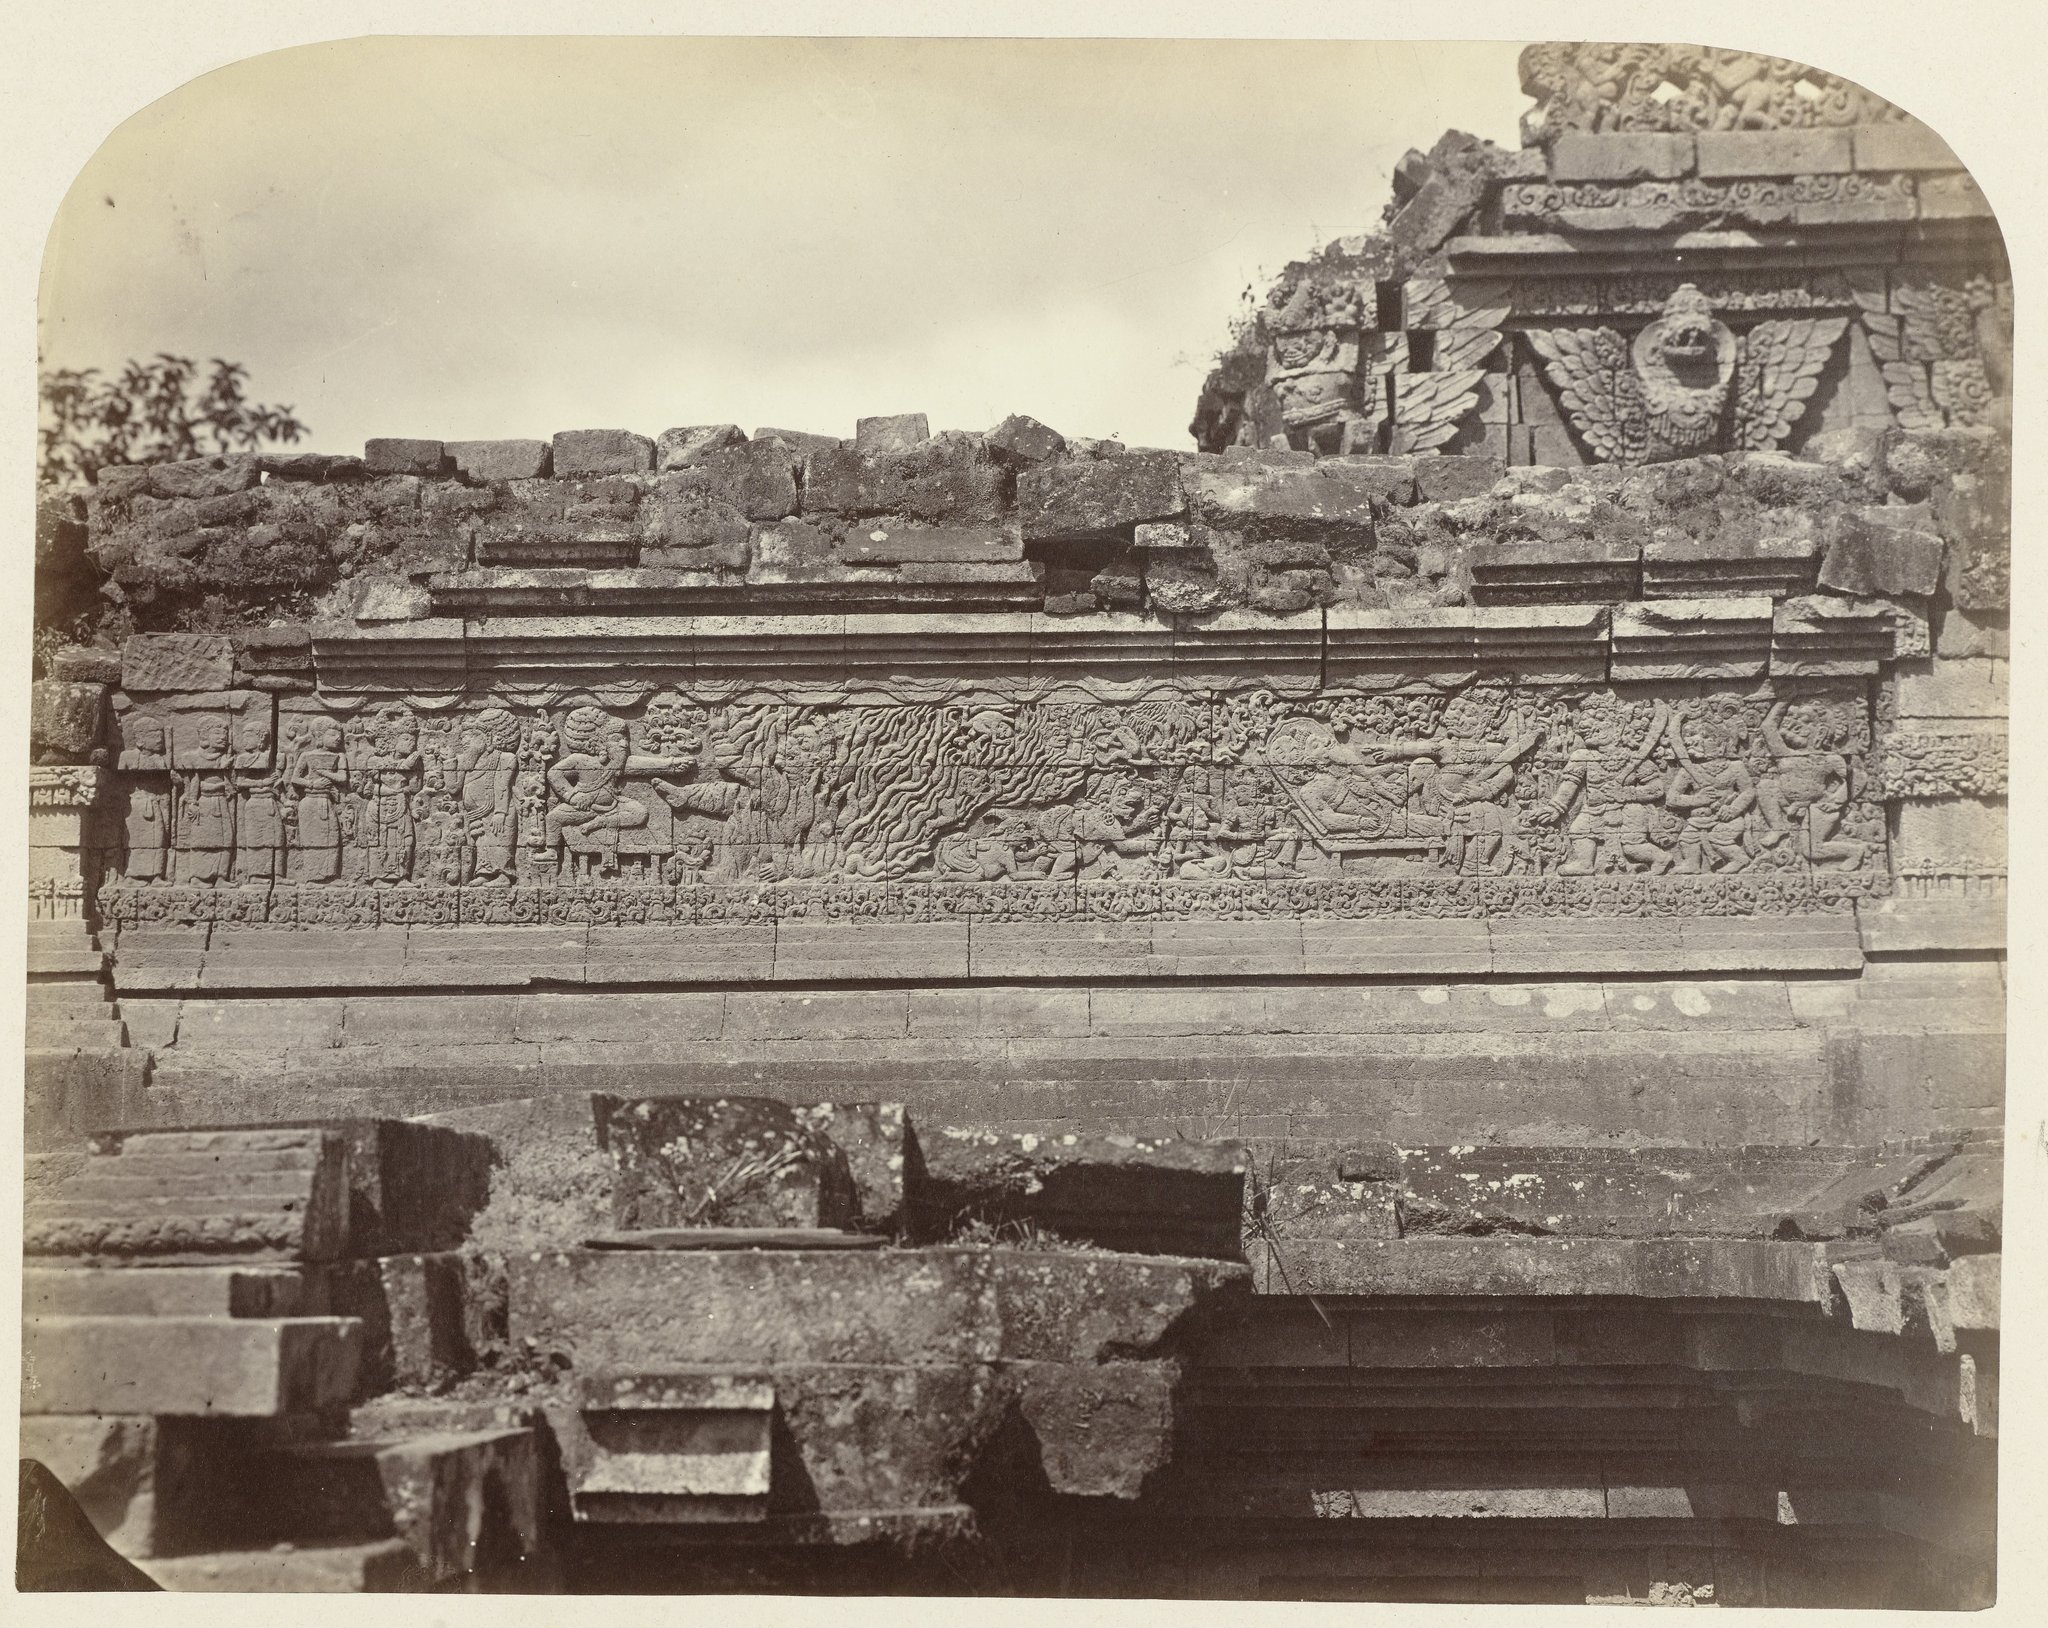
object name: photograph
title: Basreliëf met een vertelling van Krishna aan de noordzijde van Candi Panataran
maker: isidore kinsbergen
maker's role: fotograaf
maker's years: 1821-1905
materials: cardboard, paper, photographic support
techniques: albumen print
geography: java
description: Candi Panataran (Temple Complex), main Temple; Krishnayana relief no 5 (The seer Mucukunda vanquishing the demon army), second narrative register west side. Panataran, Blitar district, East Java province 1323-1347 AD.